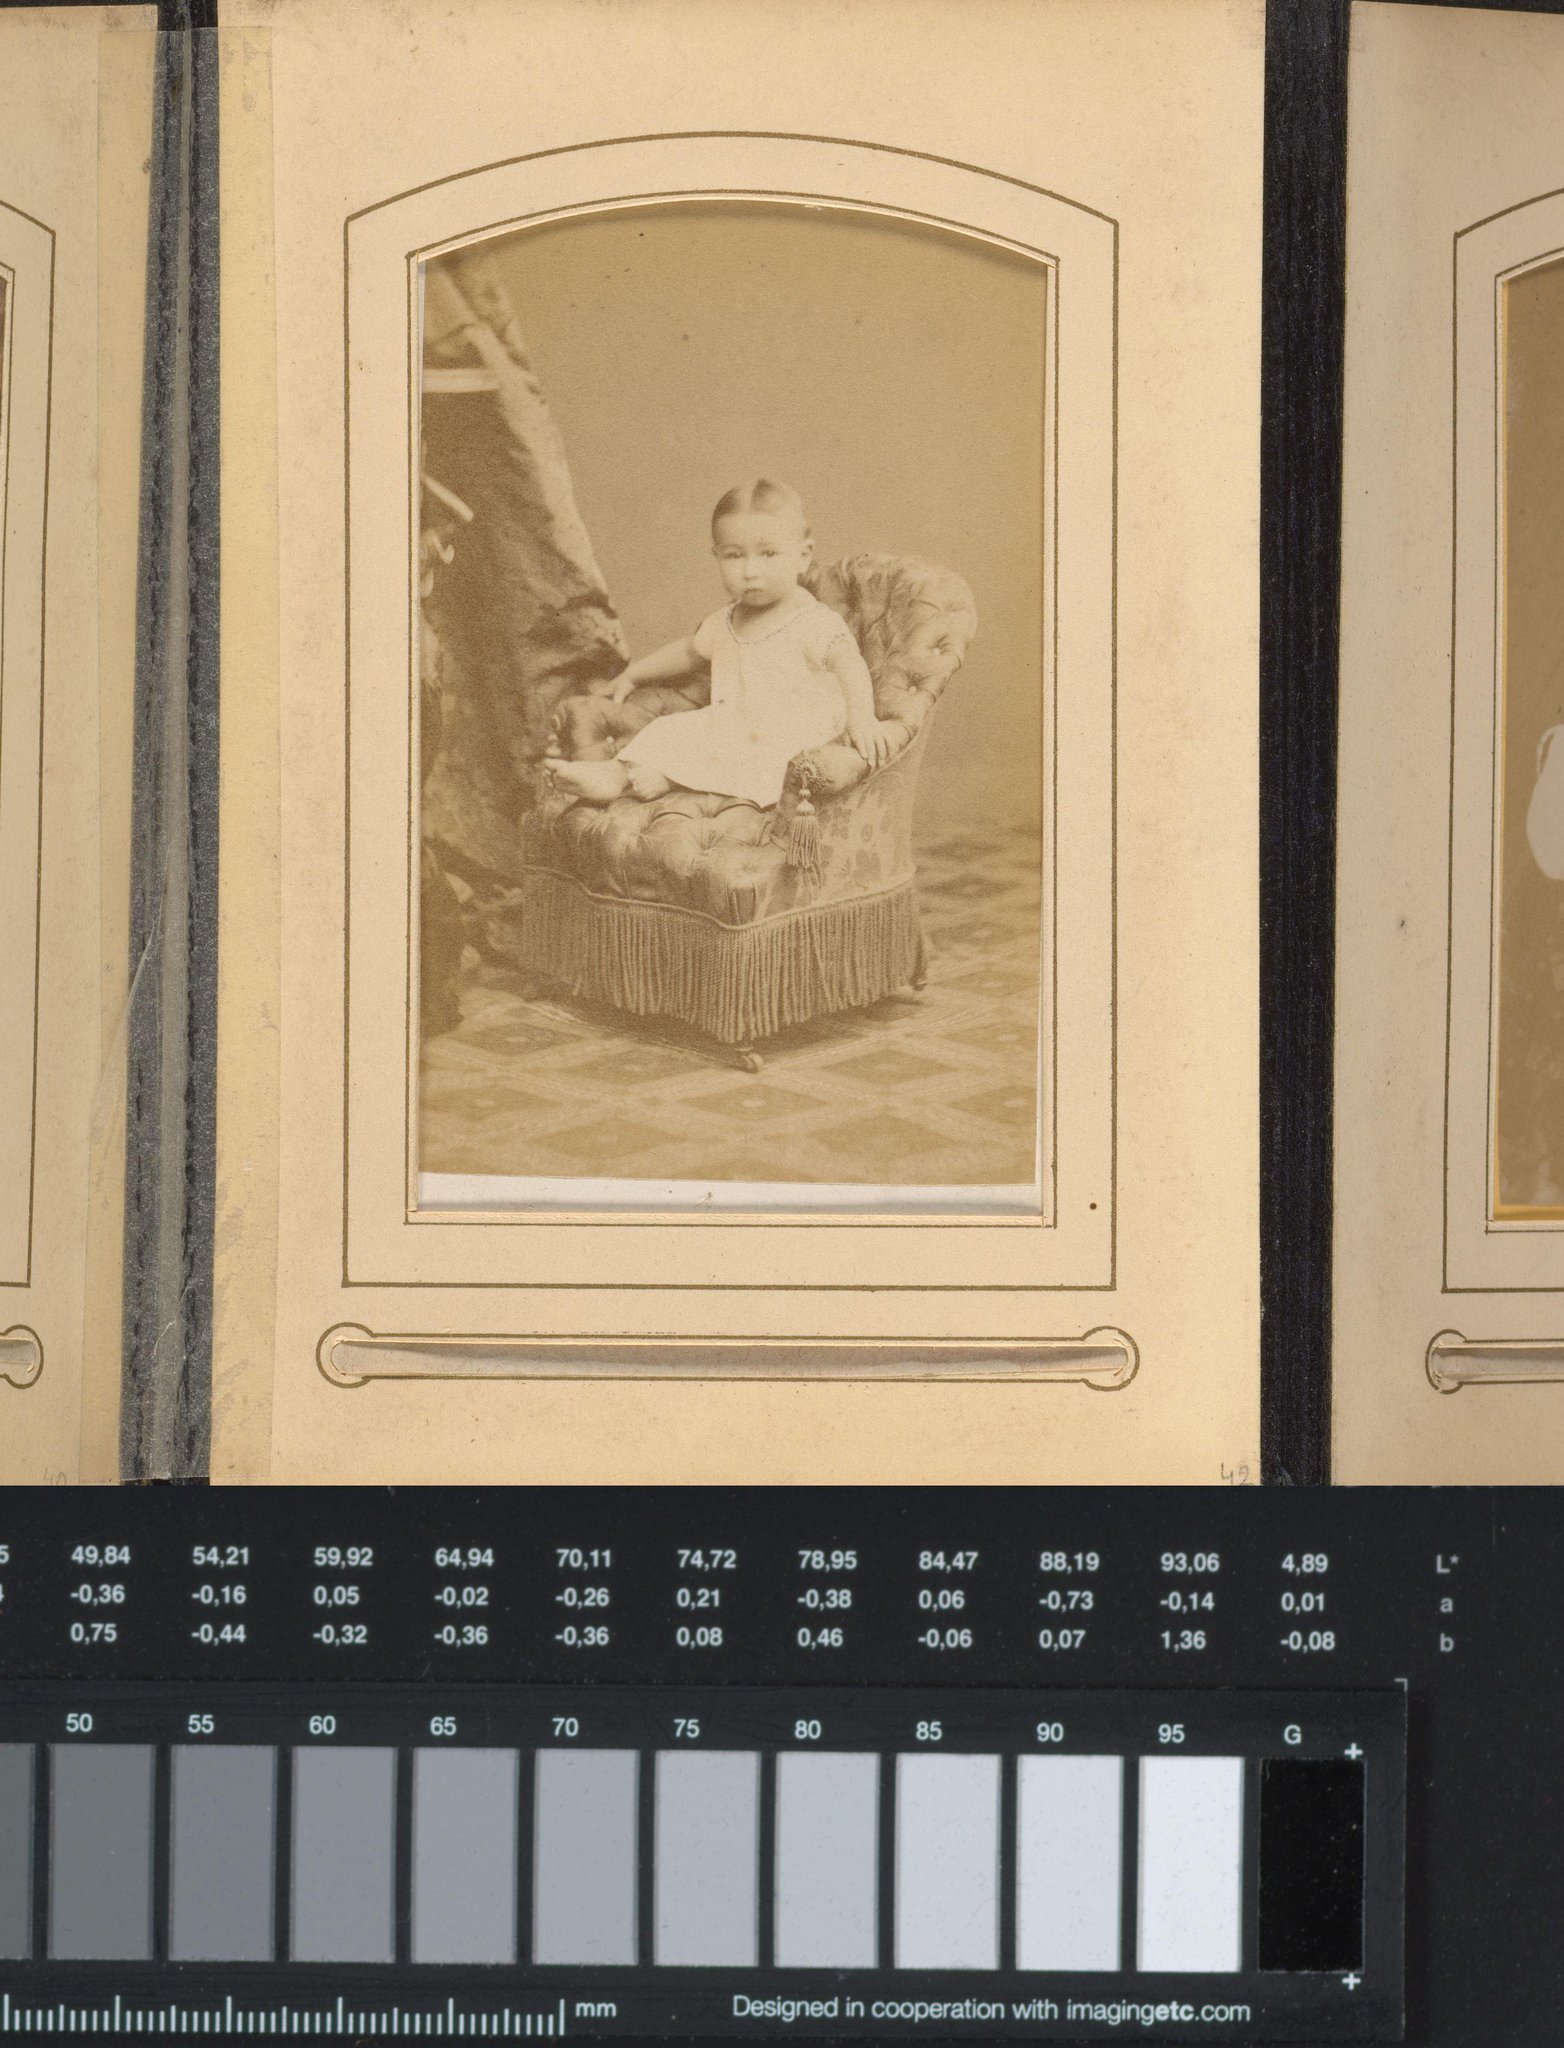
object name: carte de visite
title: Portret van een zittend kind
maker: abel bordéria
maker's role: fotograaf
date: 1874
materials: cardboard, photographic support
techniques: albumen print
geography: reims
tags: sitting figure, historical persons, tot, toddler ~ the ages of man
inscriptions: inscription: ‘Atelier/ Place/ Drouet d'Erlon/ 6/ Reims/ A. Bordéria/ Maison à/ St. Quentin,/ Place du Lycée/ No. 2/ Tous les Clichés sont conservés.’, dedication: ‘A Monsieur Schuuren/ fils, souvenir de bonne/ amitié/ Reims le 22 7bre 1874/ L. Lanso[n]’